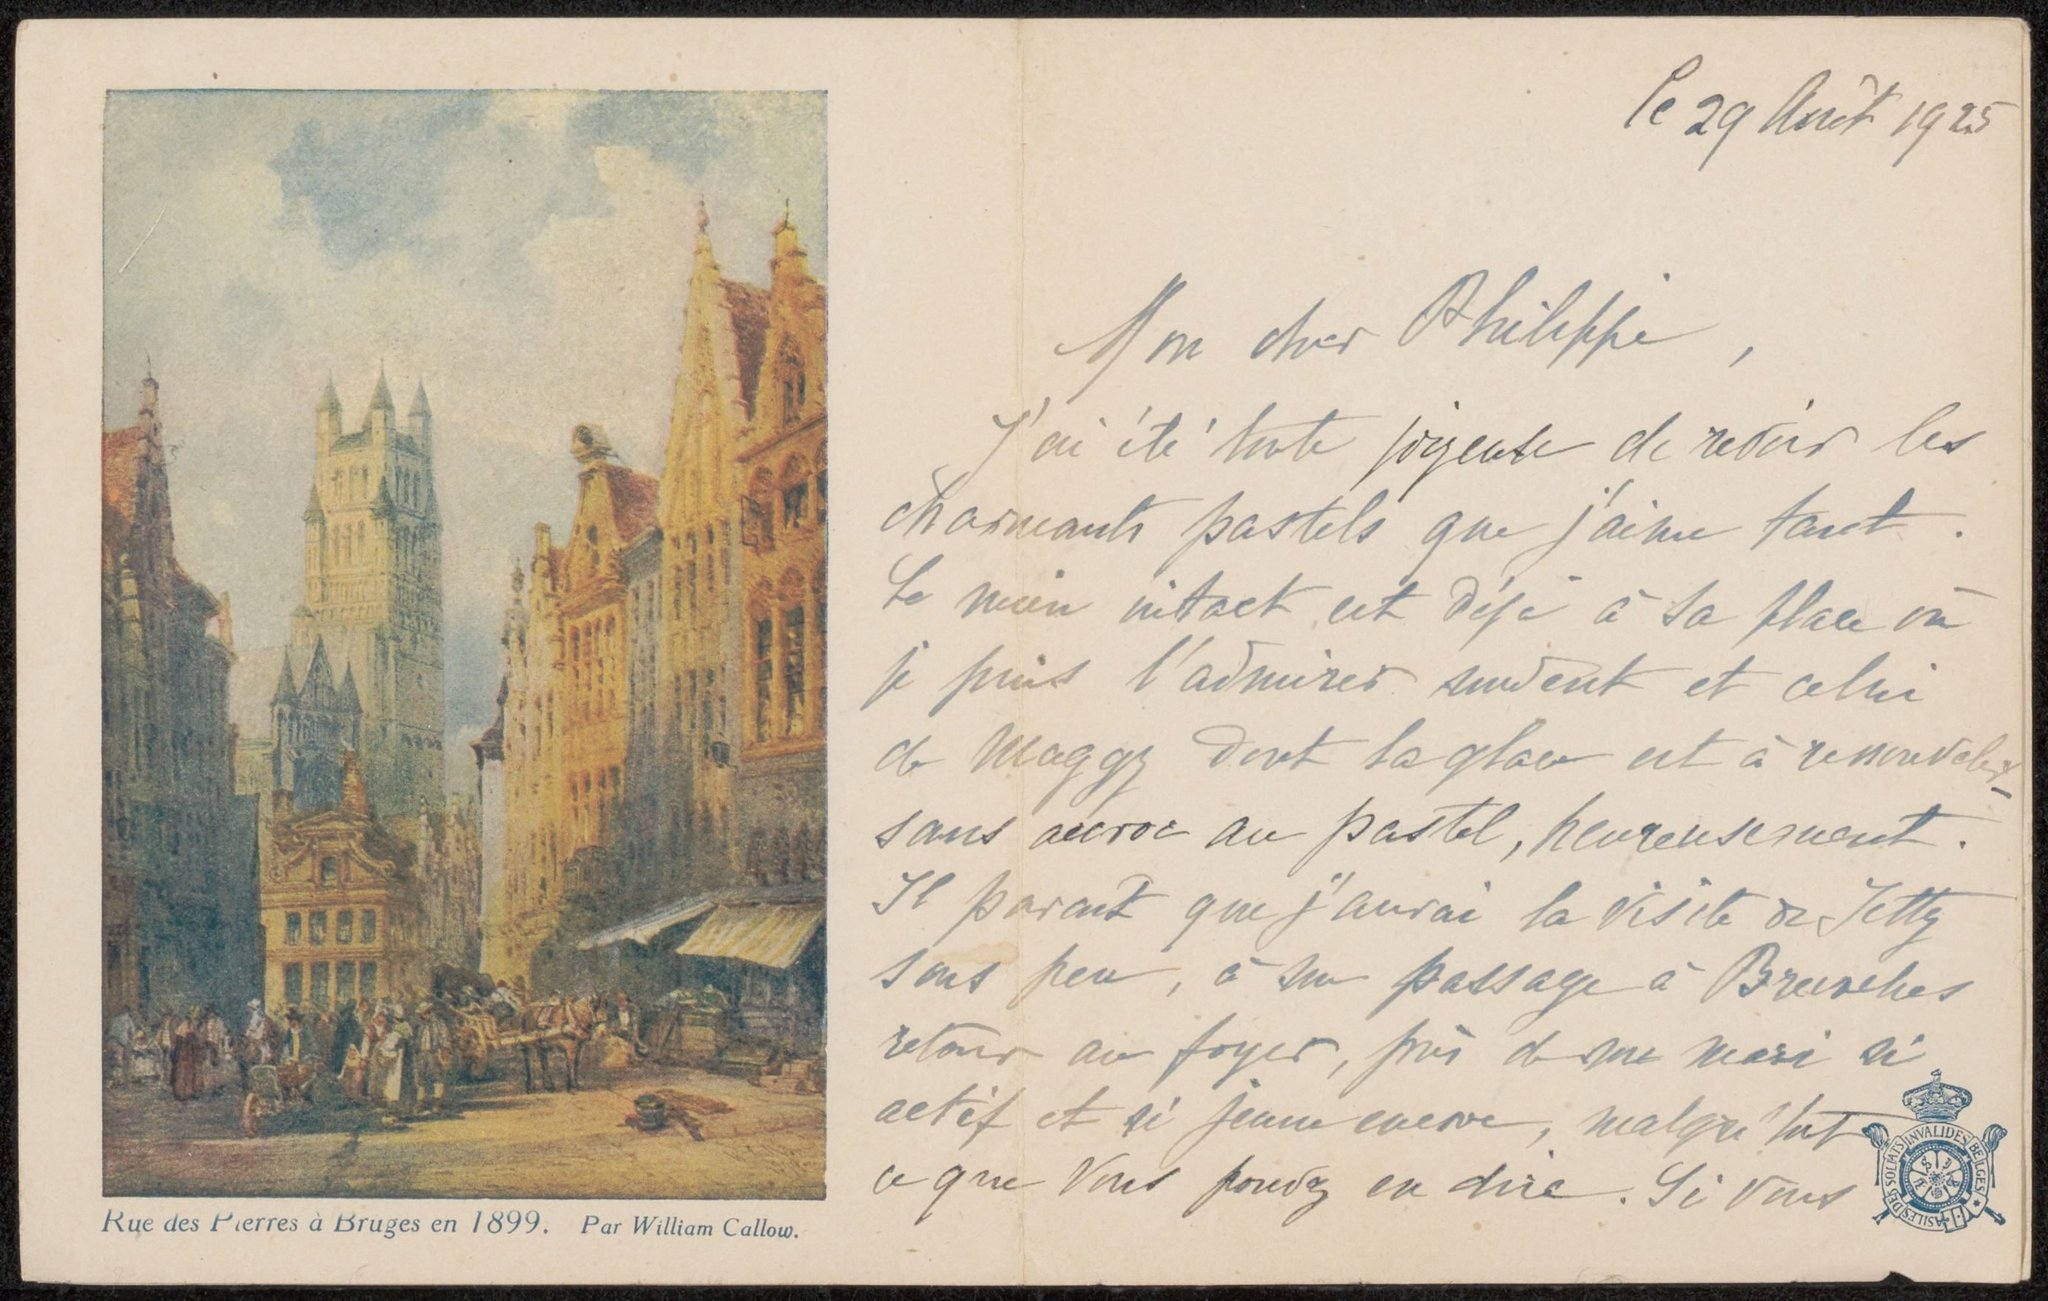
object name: letter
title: Brief aan Philip Zilcken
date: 1925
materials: ink, paper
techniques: pen, writing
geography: uccle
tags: the hague, painter, draughtsman, philip zilcken, brussels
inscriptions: collector's mark: ‘RPK’